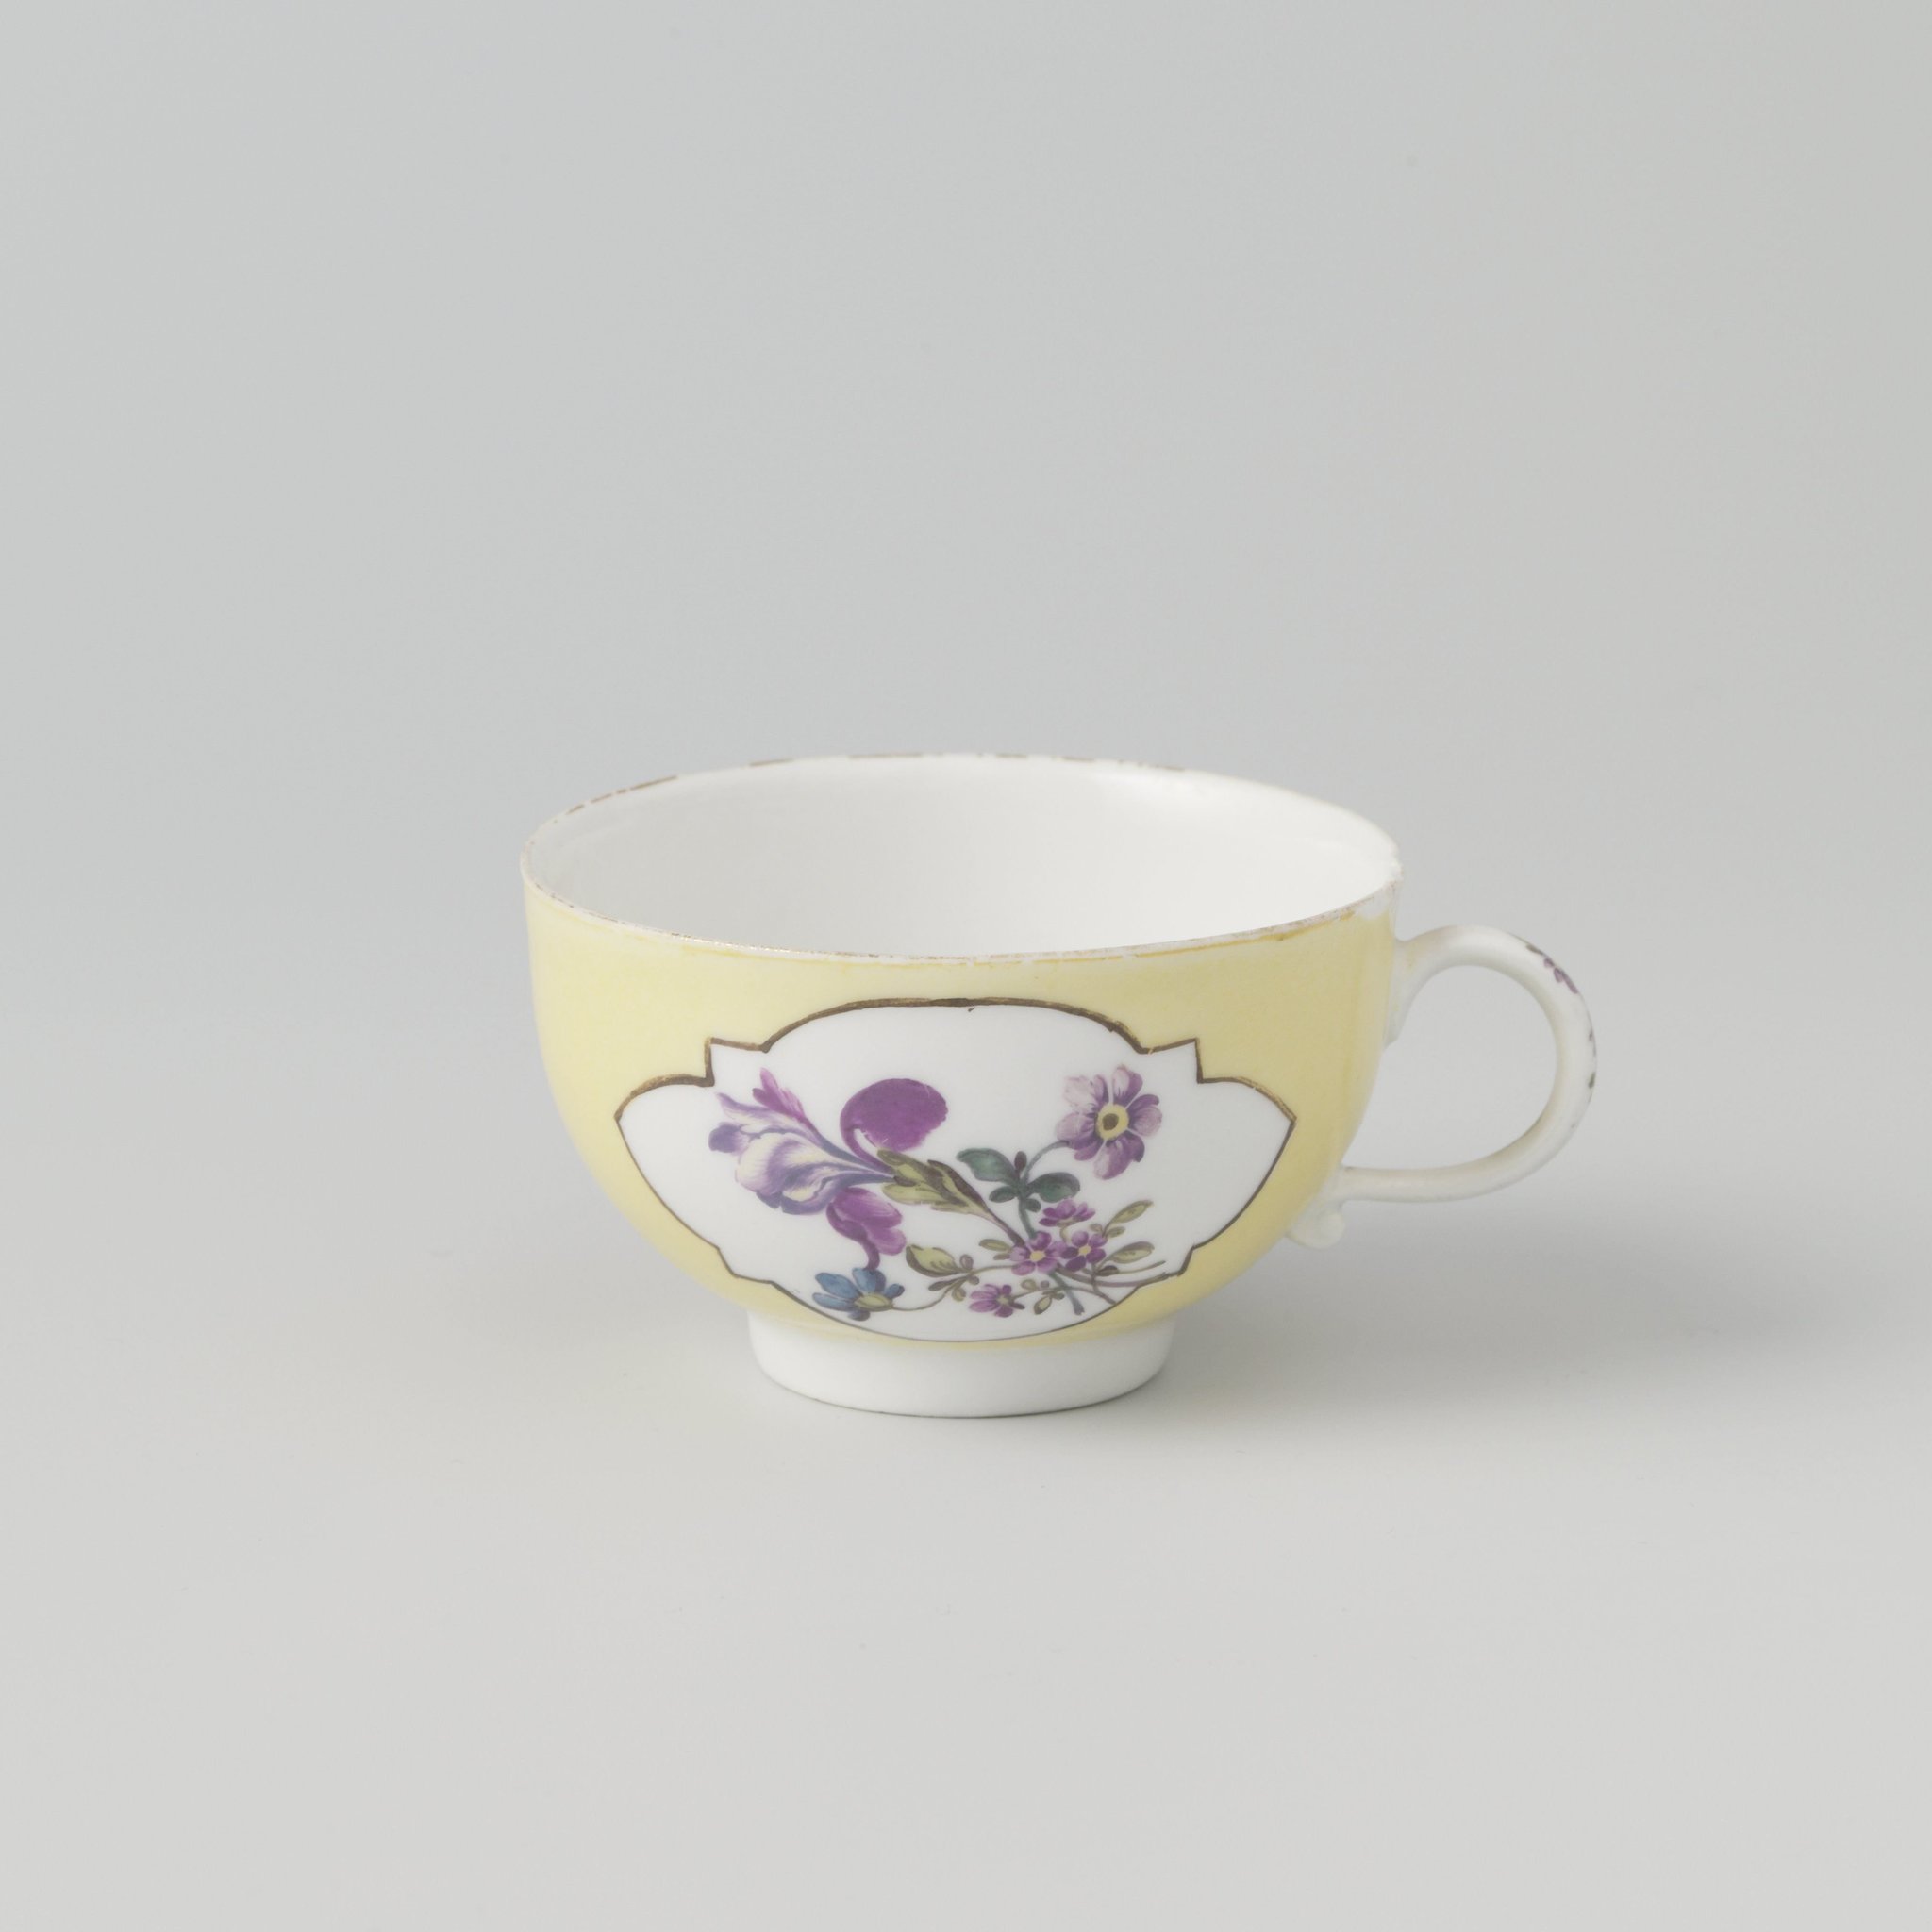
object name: eating drinking utensil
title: Kop, veelkleurig beschilderd met Deutsche Blumen in uitgespaarde vierpassen in een gele fond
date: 1765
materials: porcelain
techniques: painted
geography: meissen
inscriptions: factory mark, mold mark: ‘66 (of 99)’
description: Tea service. Porcelain. Meissen, c. 1770. Jonkvrouwe A.C.A.J. Clifford bequest, 1960.